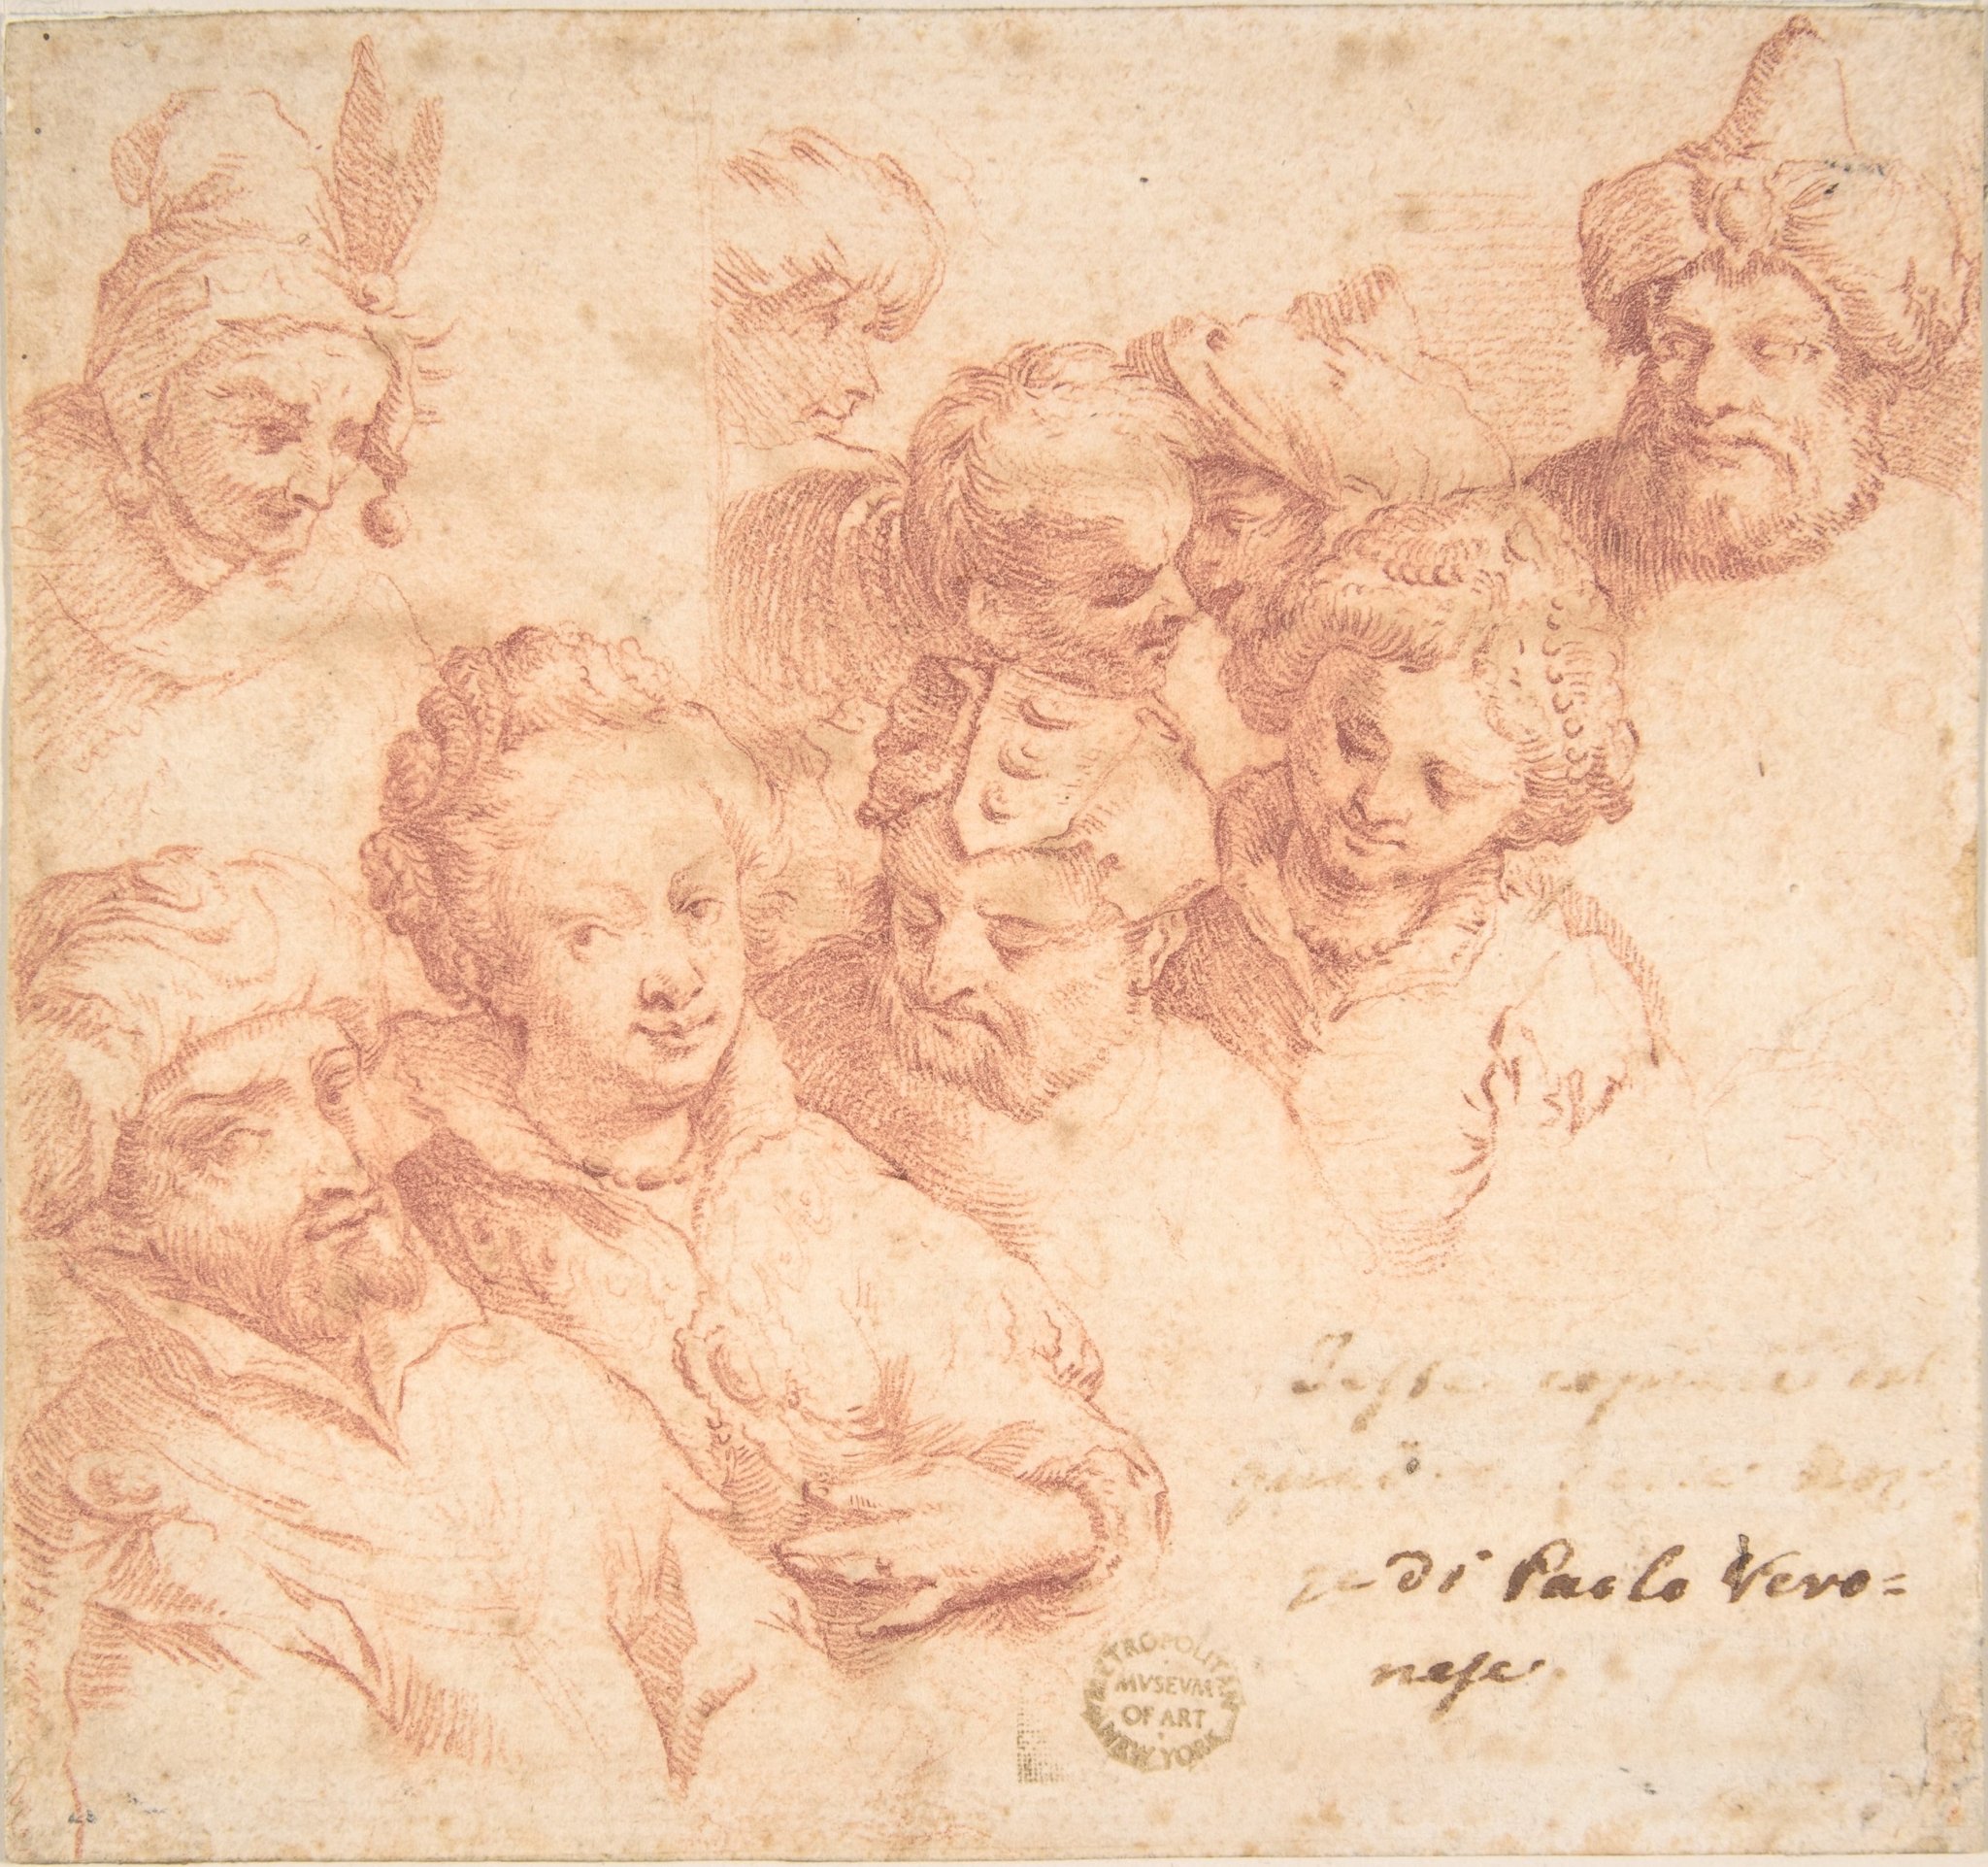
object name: drawing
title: Nine heads after Paolo Veronese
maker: anonymous, italian, roman-bolognese, 17th century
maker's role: artist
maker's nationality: italian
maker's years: 1600-1700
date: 1601-1700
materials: chalk, paper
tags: heads,men,women